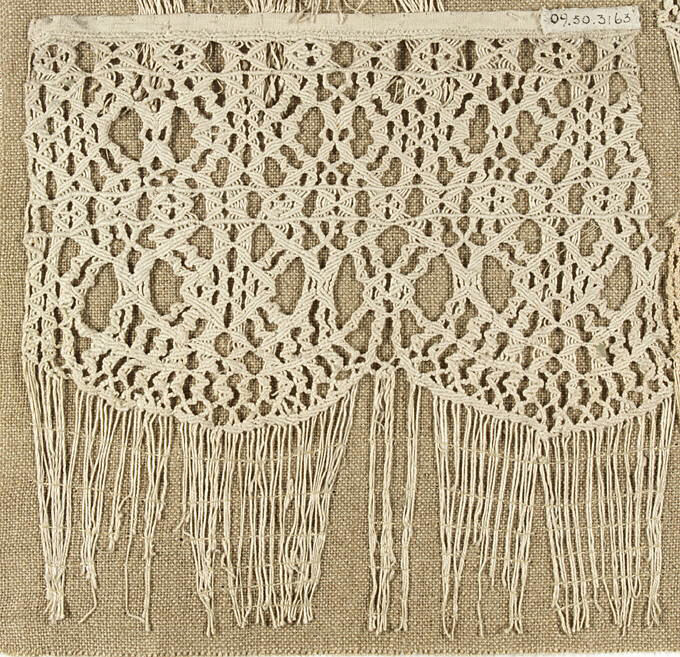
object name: fragment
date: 1701-1800